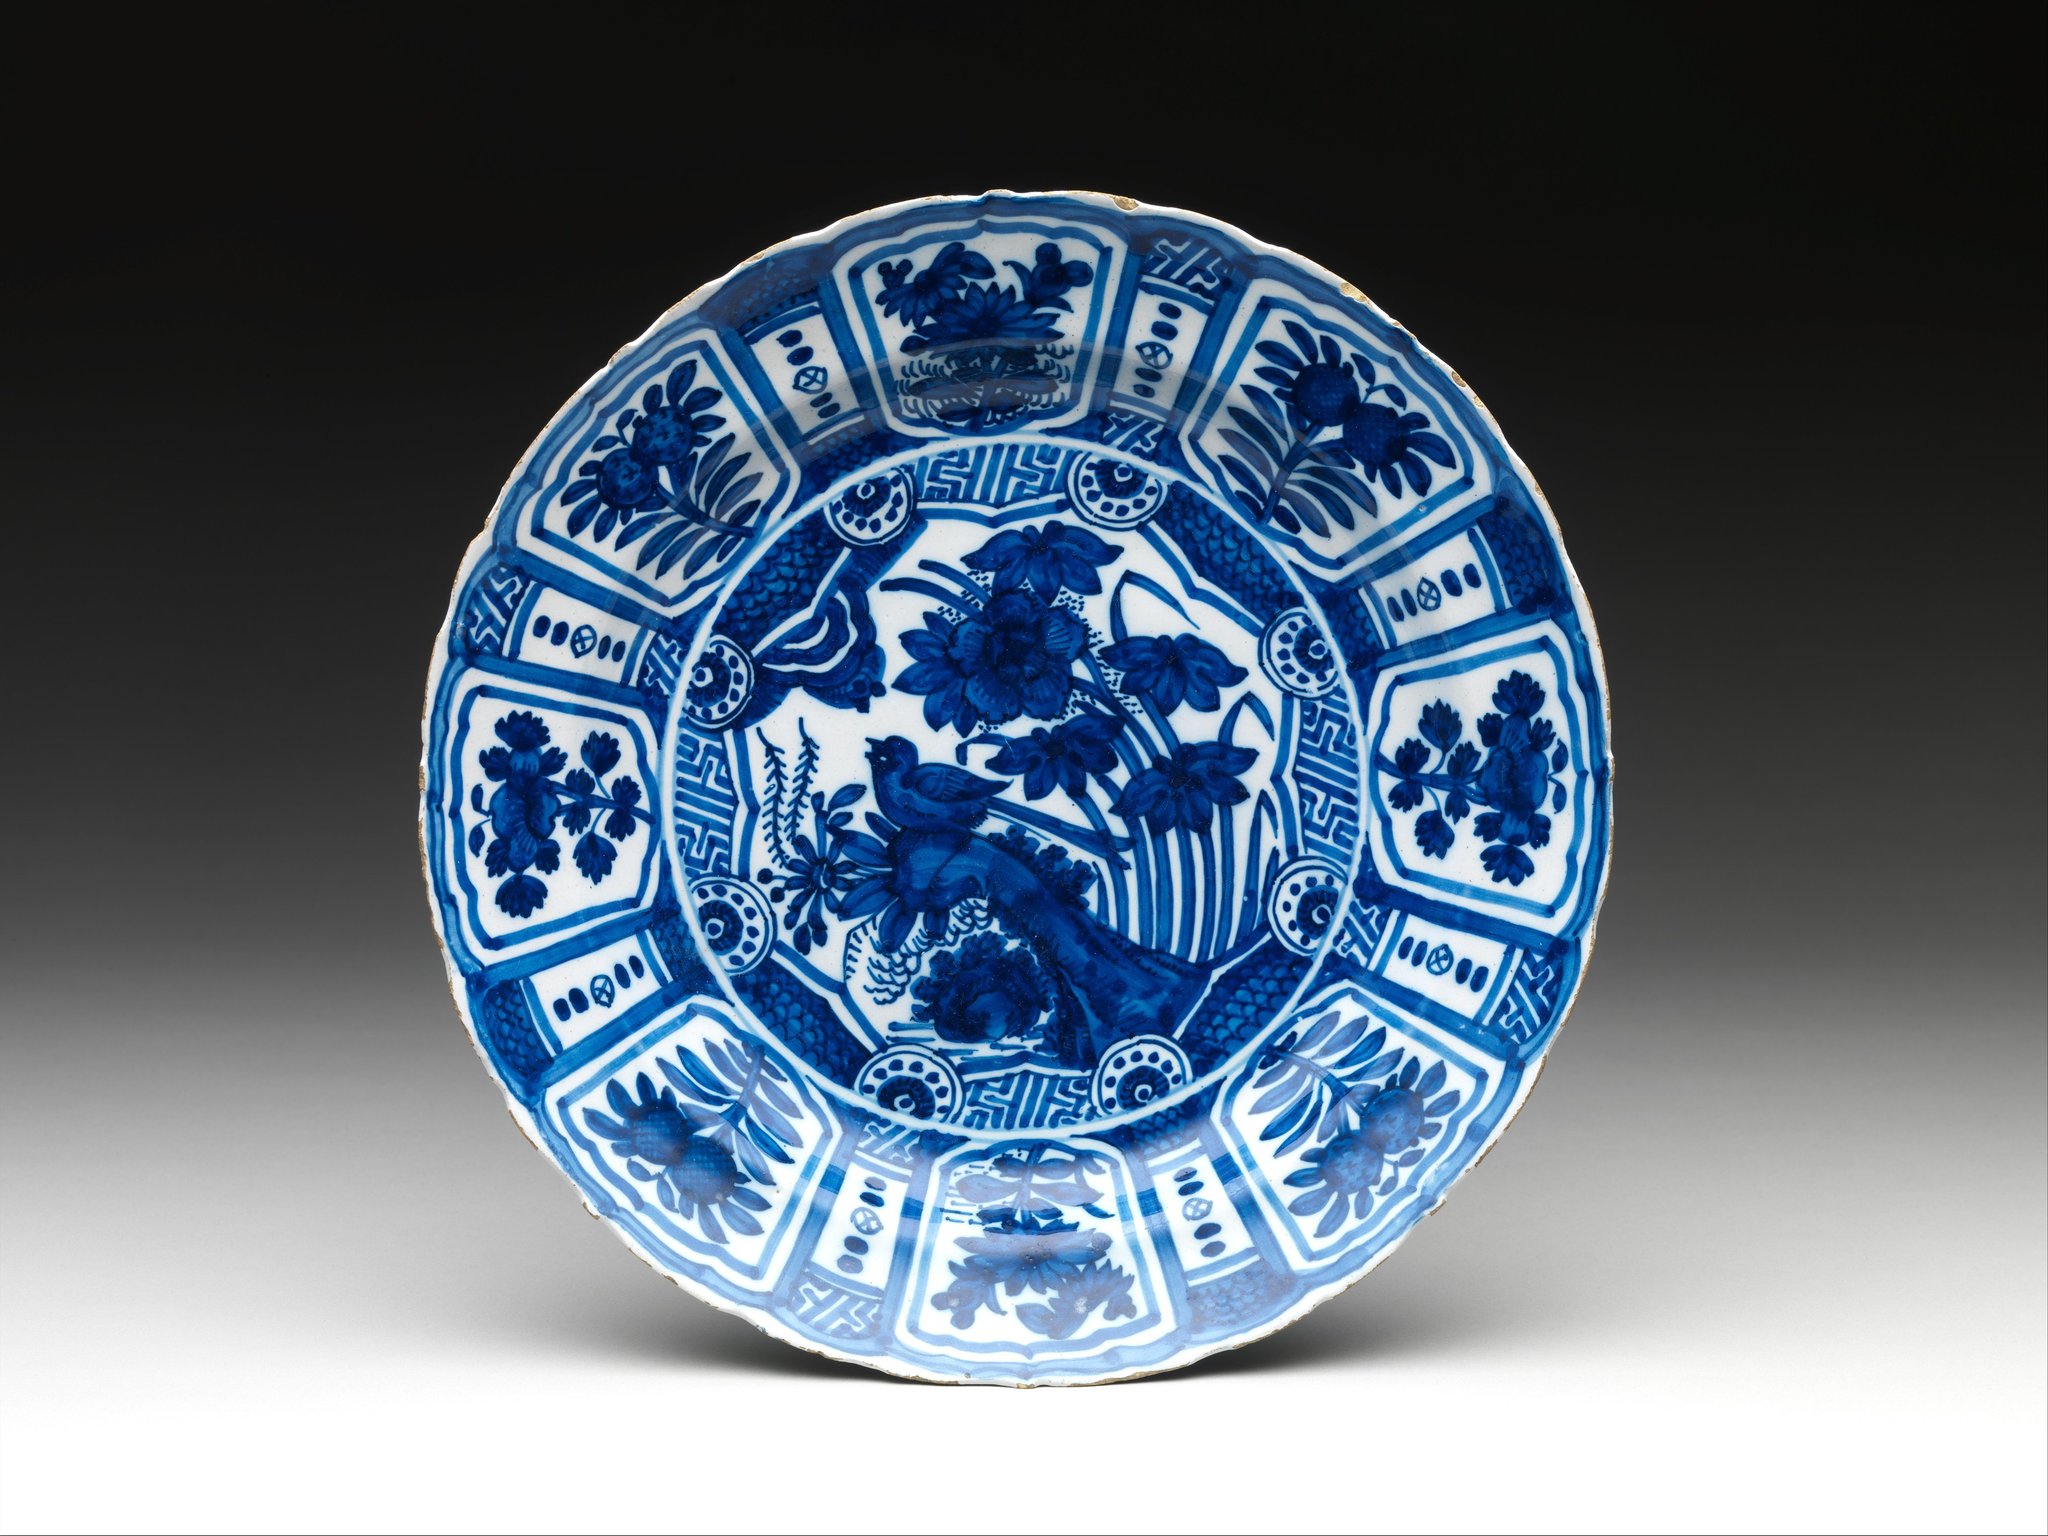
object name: dish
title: Dish with flowers and birds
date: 1660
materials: cobalt, earthenware, pigment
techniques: glazing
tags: birds,flowers